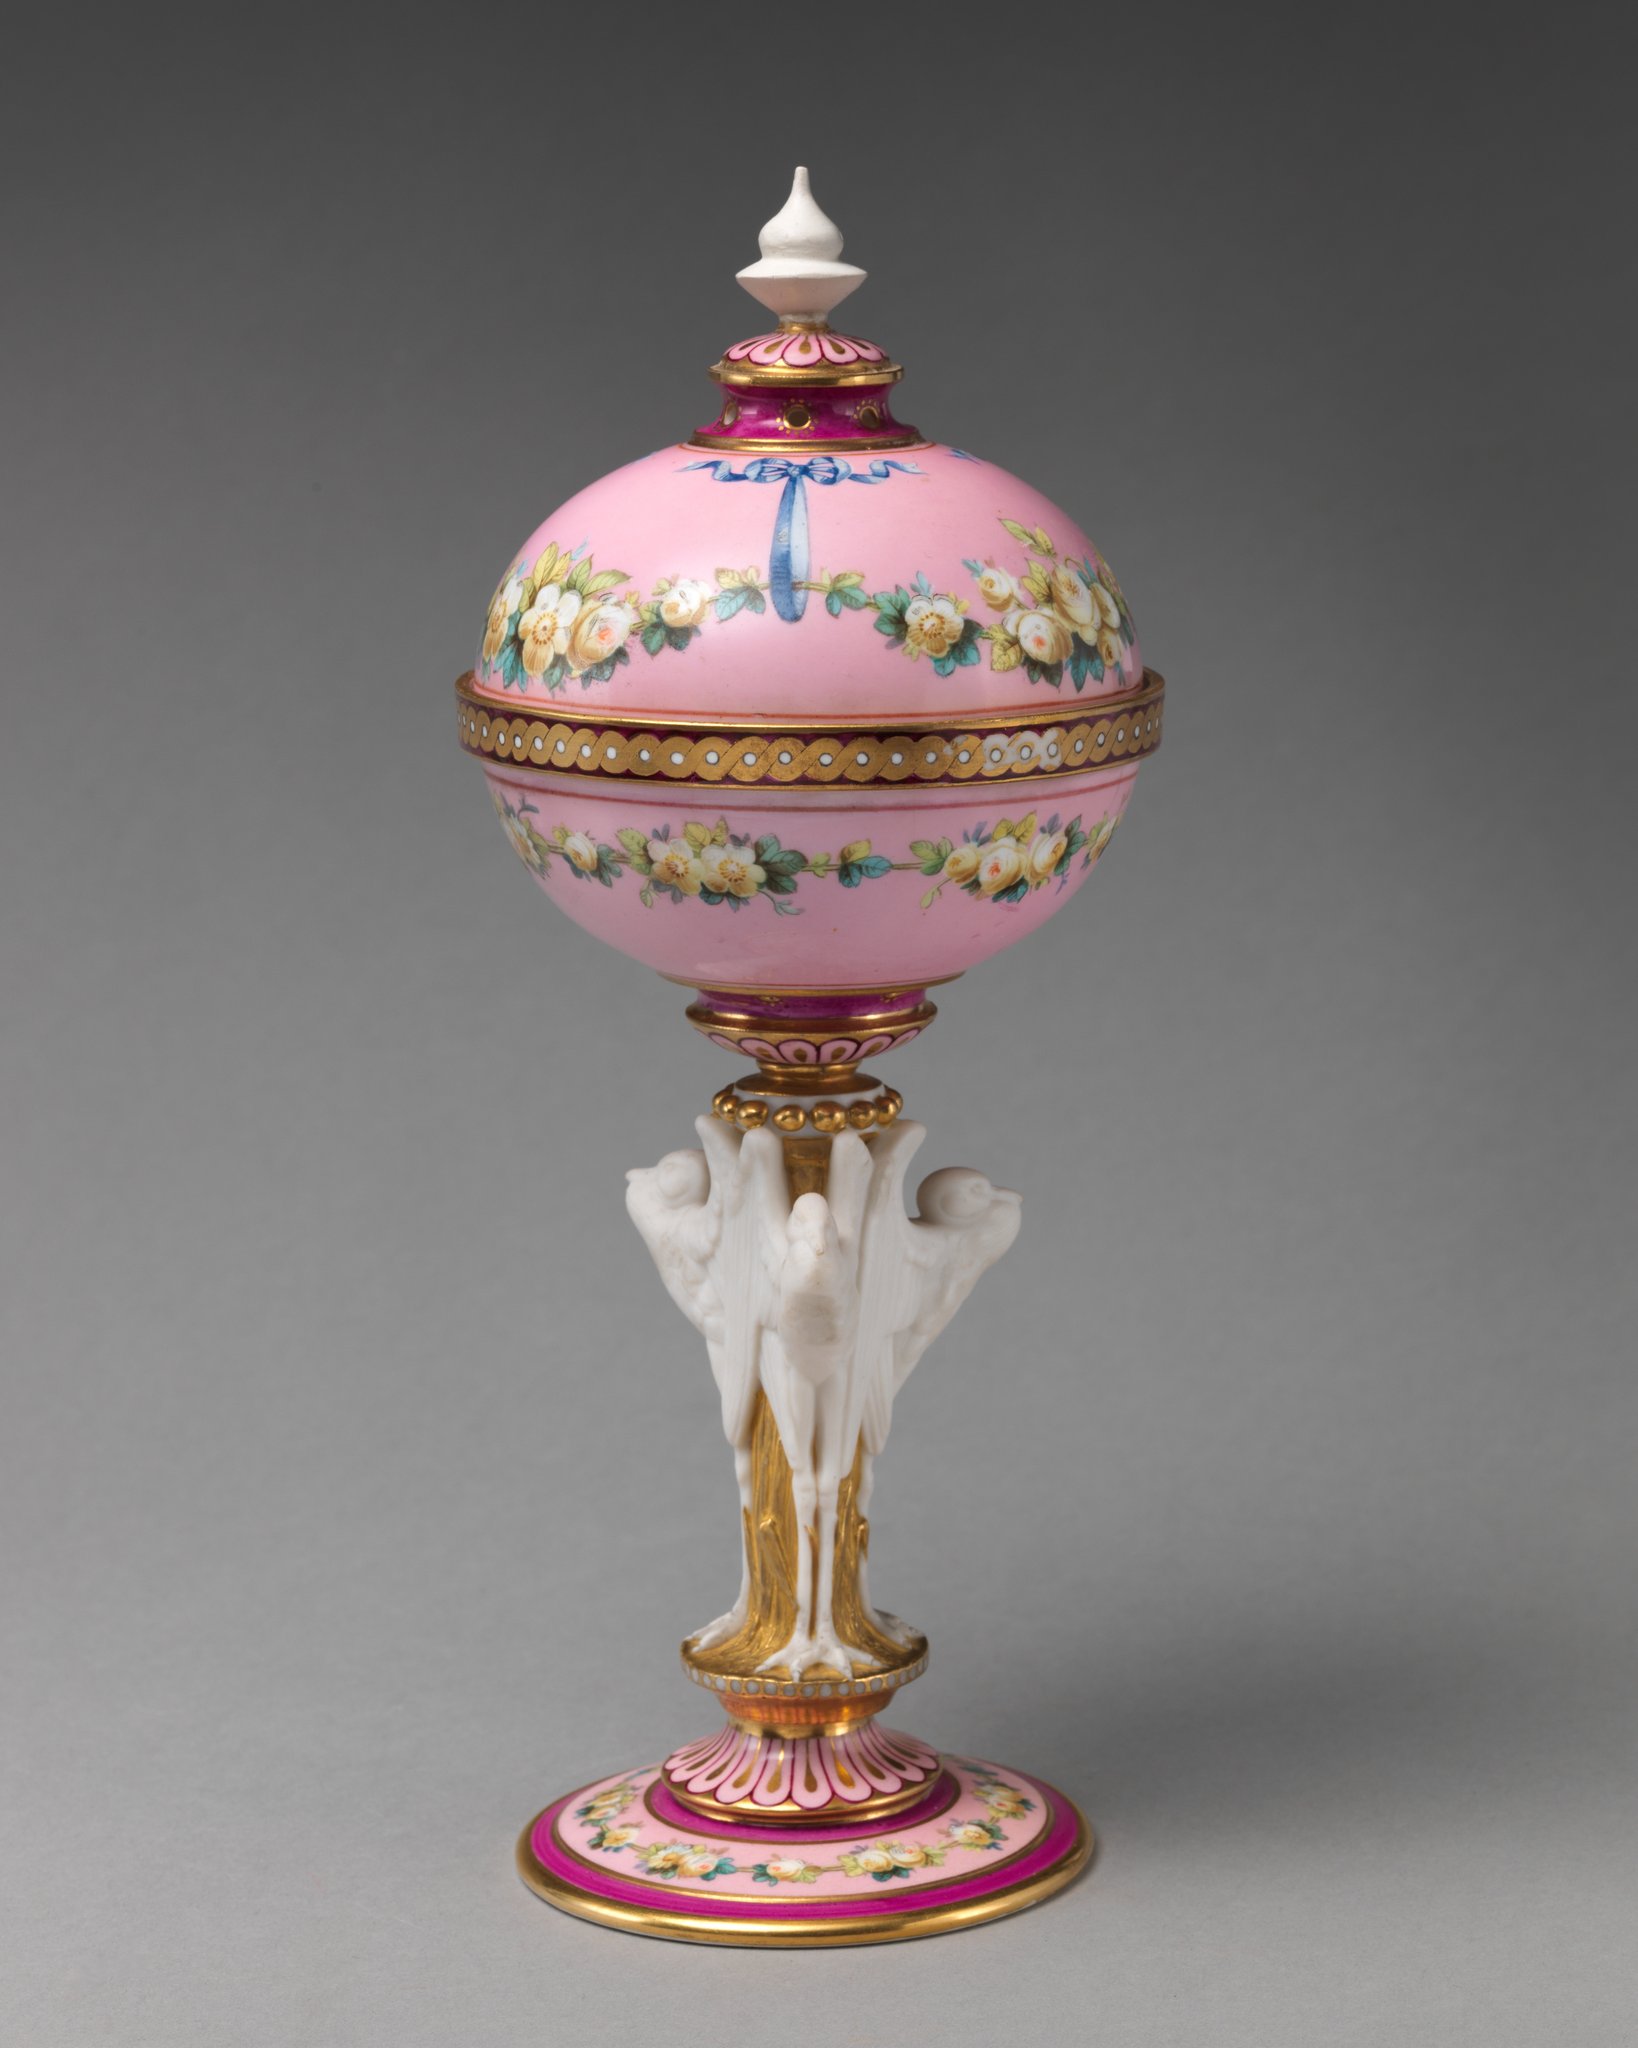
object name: potpourri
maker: minton(s)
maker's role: maker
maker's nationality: british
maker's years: 1793-2001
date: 1860-1870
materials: bone china, porcelain